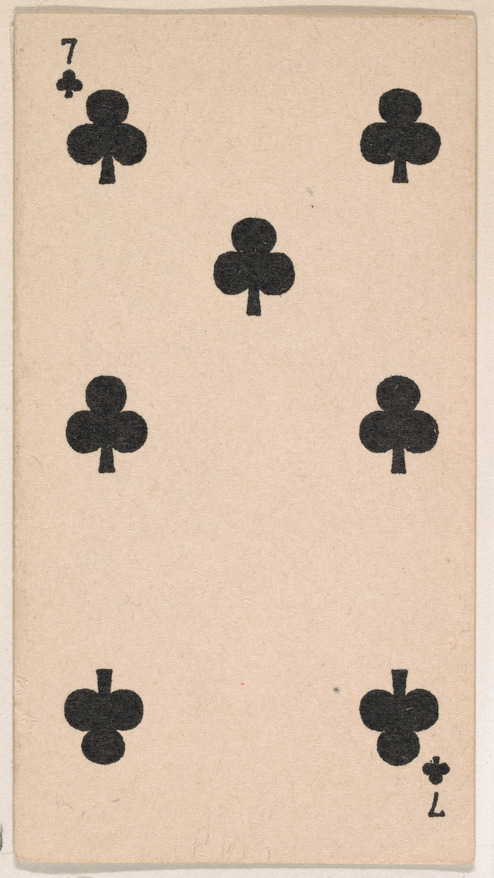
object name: print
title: Seven of Clubs, from the Transparent Playing Cards series (N220) issued by Kinney Bros.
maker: kinney brothers tobacco company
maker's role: publisher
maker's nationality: american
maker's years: 1869-2011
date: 1888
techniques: color lithograph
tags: playing cards